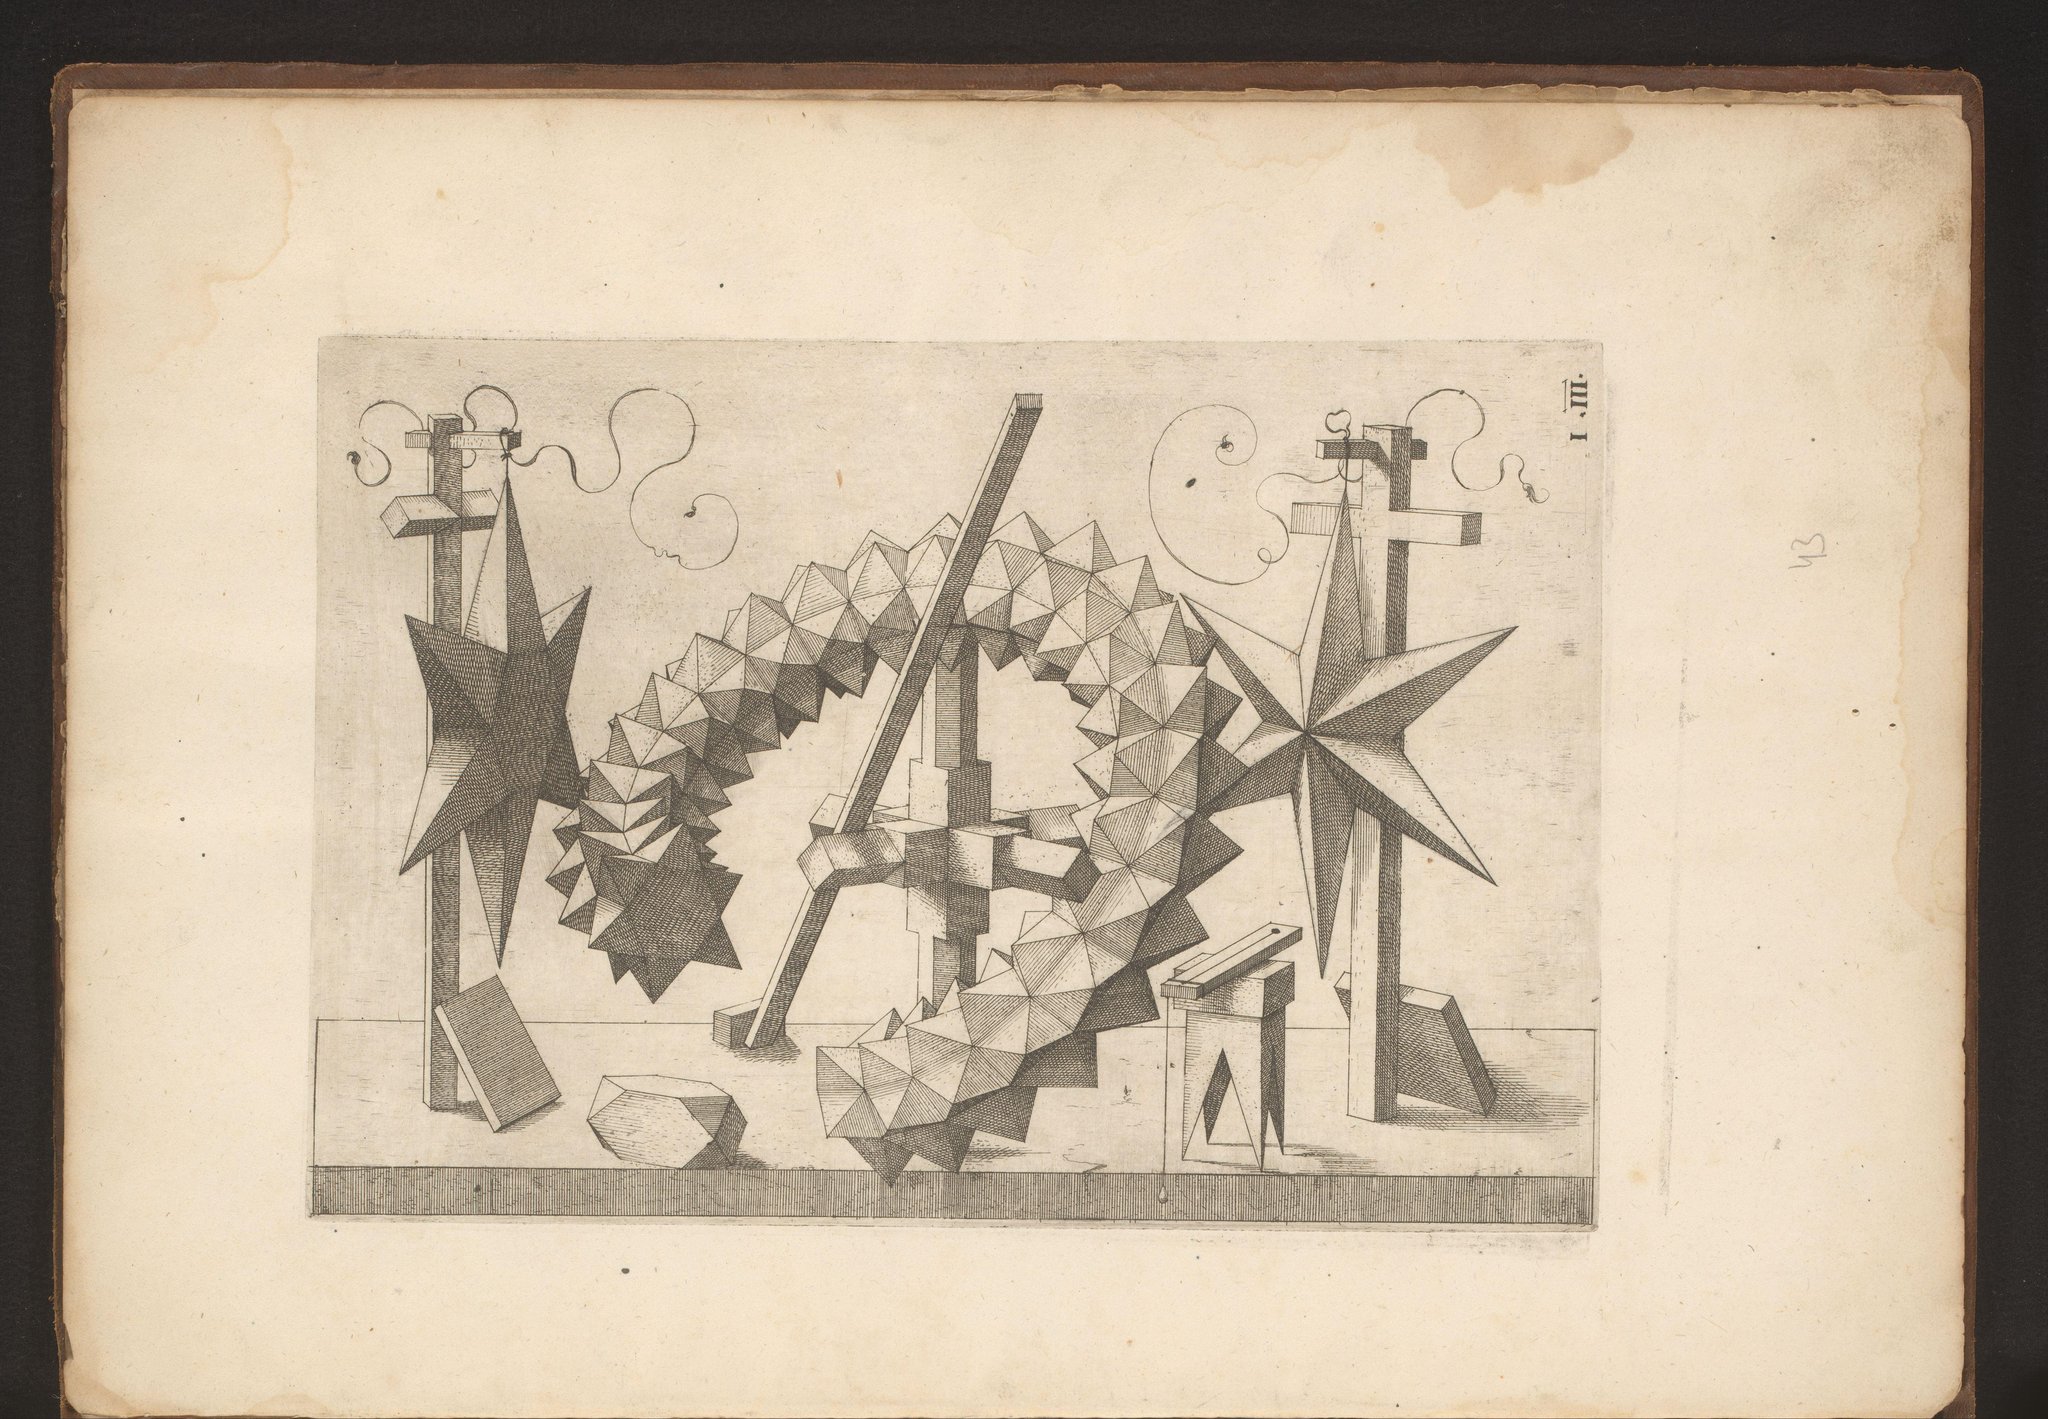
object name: print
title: Veelvlak met een torus als uitgangspunt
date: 1568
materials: paper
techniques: etching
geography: nuremberg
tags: other polyhedrons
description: Geometrische figuren (polyhedra) zoals twee sterren en kruizen omringen het meest complexe centrale veelvlak. Genummerd: J.III. Deze prent maakt deel uit van een boek.